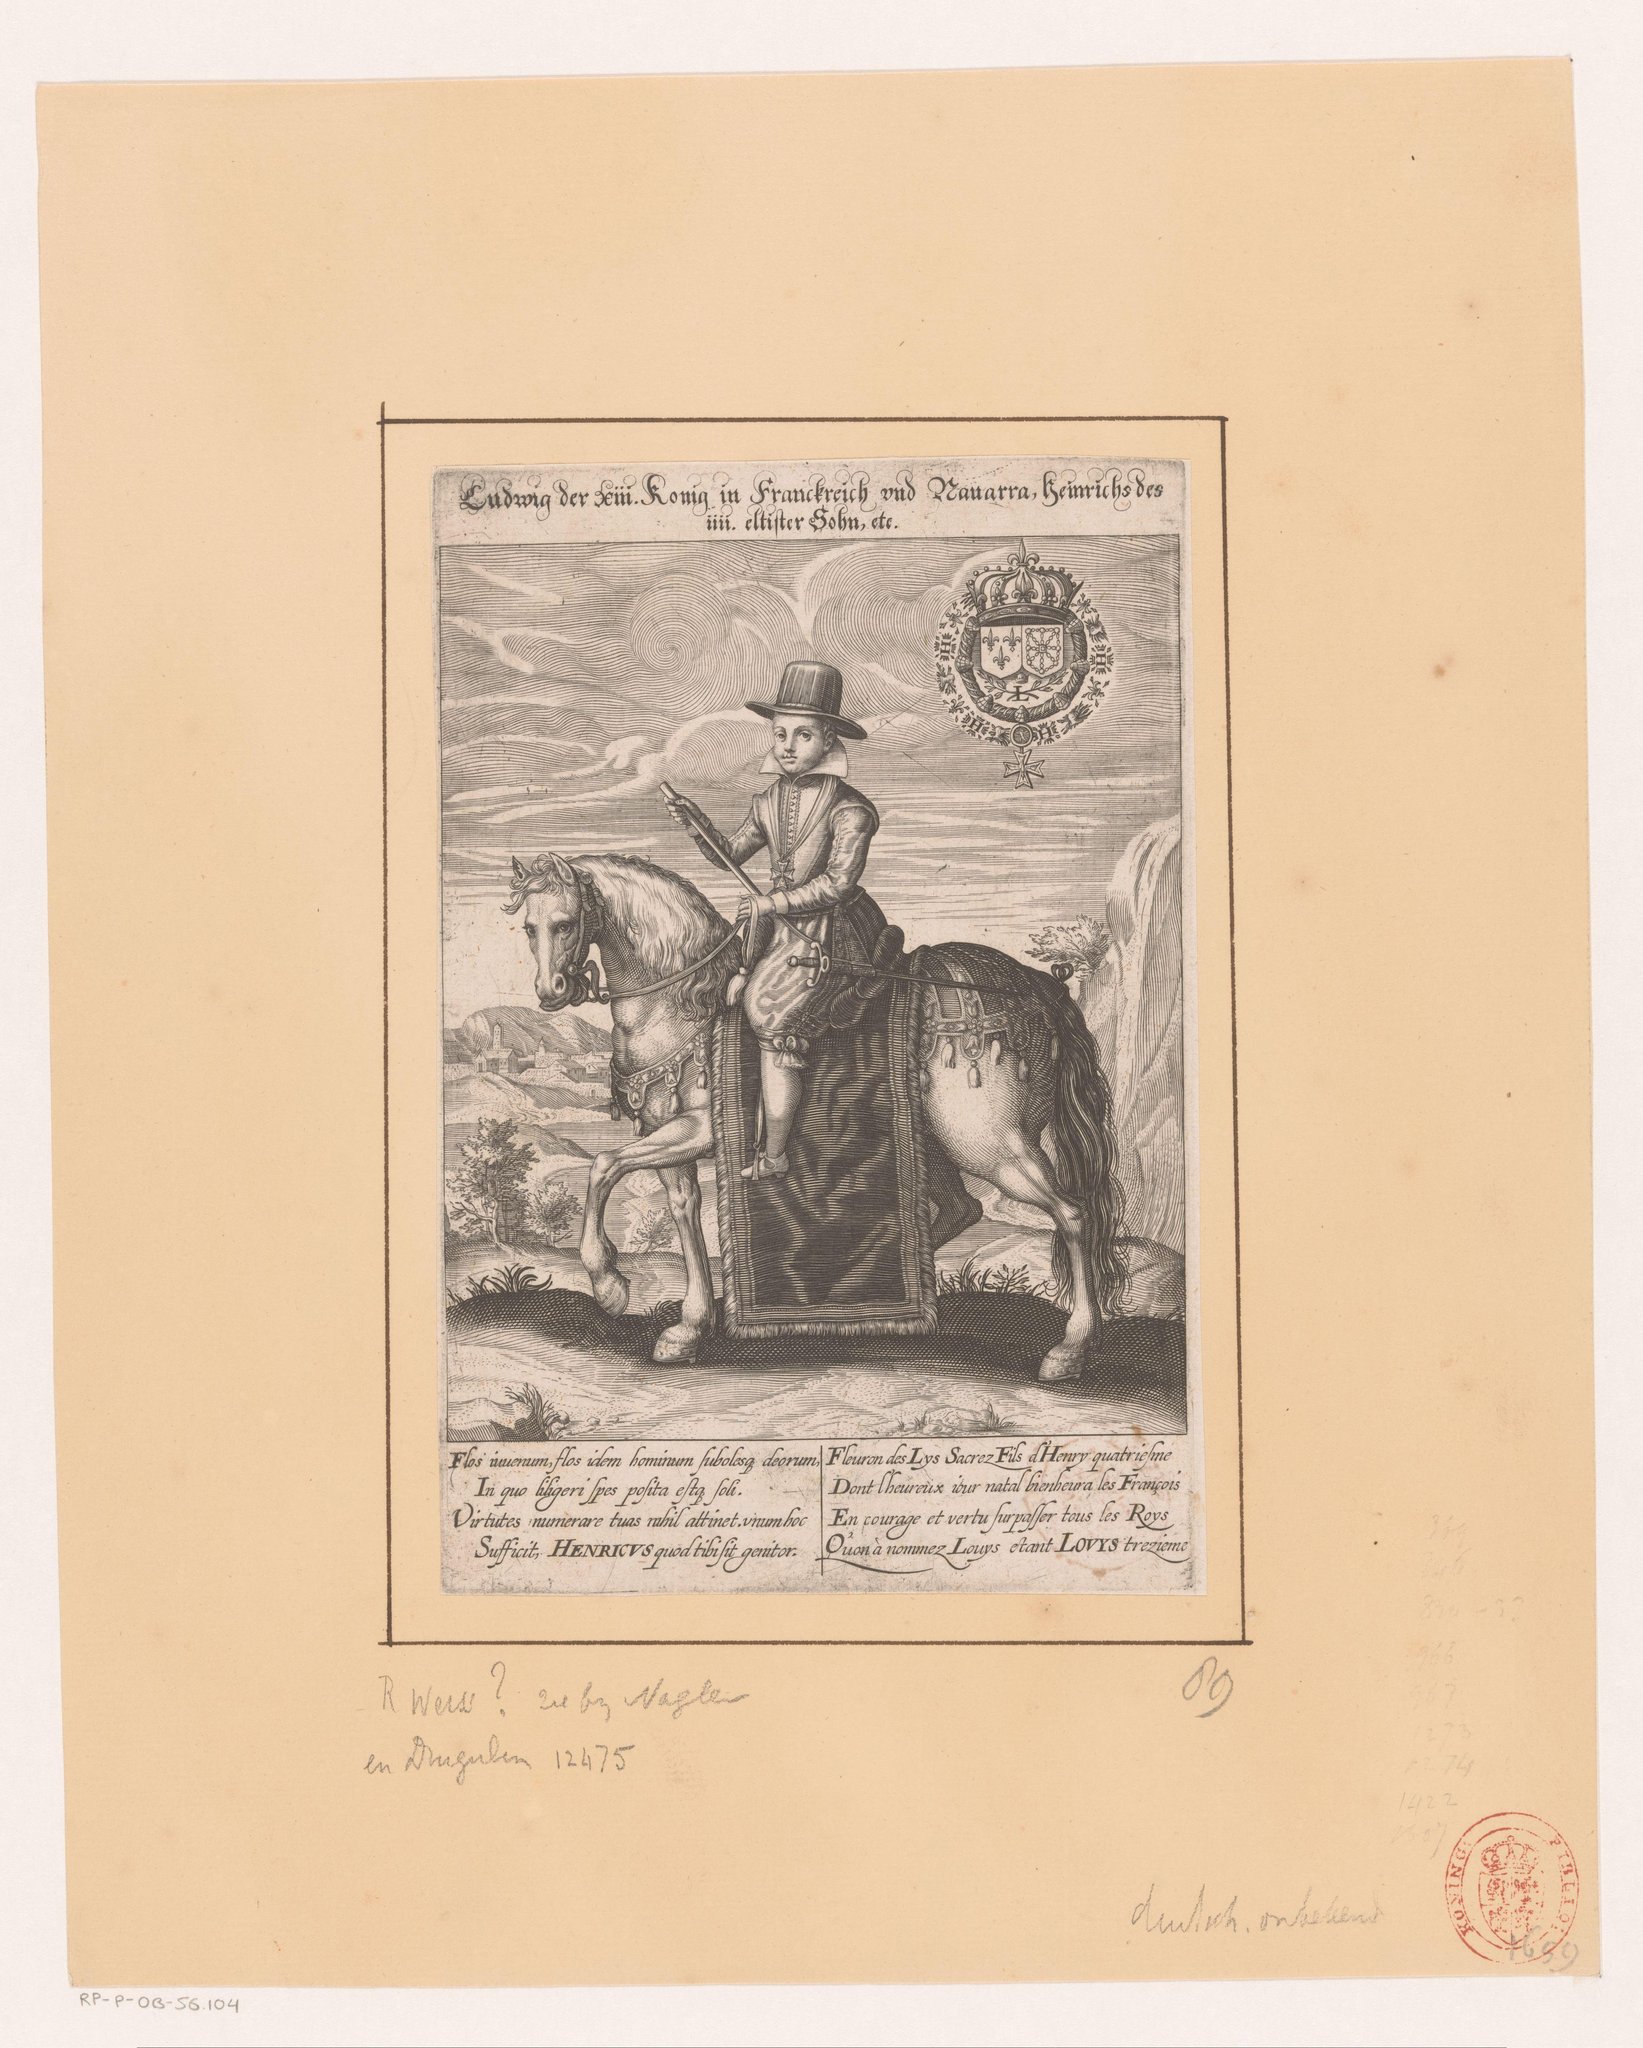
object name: print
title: Ruiterportret van Lodewijk XIII als kind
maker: robert weiss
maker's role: print maker, publisher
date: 1610-1699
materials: paper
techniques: engraving, intaglio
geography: germany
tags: lodewijk xiii (koning van frankrijk), equestrian state-portrait, historical persons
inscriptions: collector's mark: Lugt 240